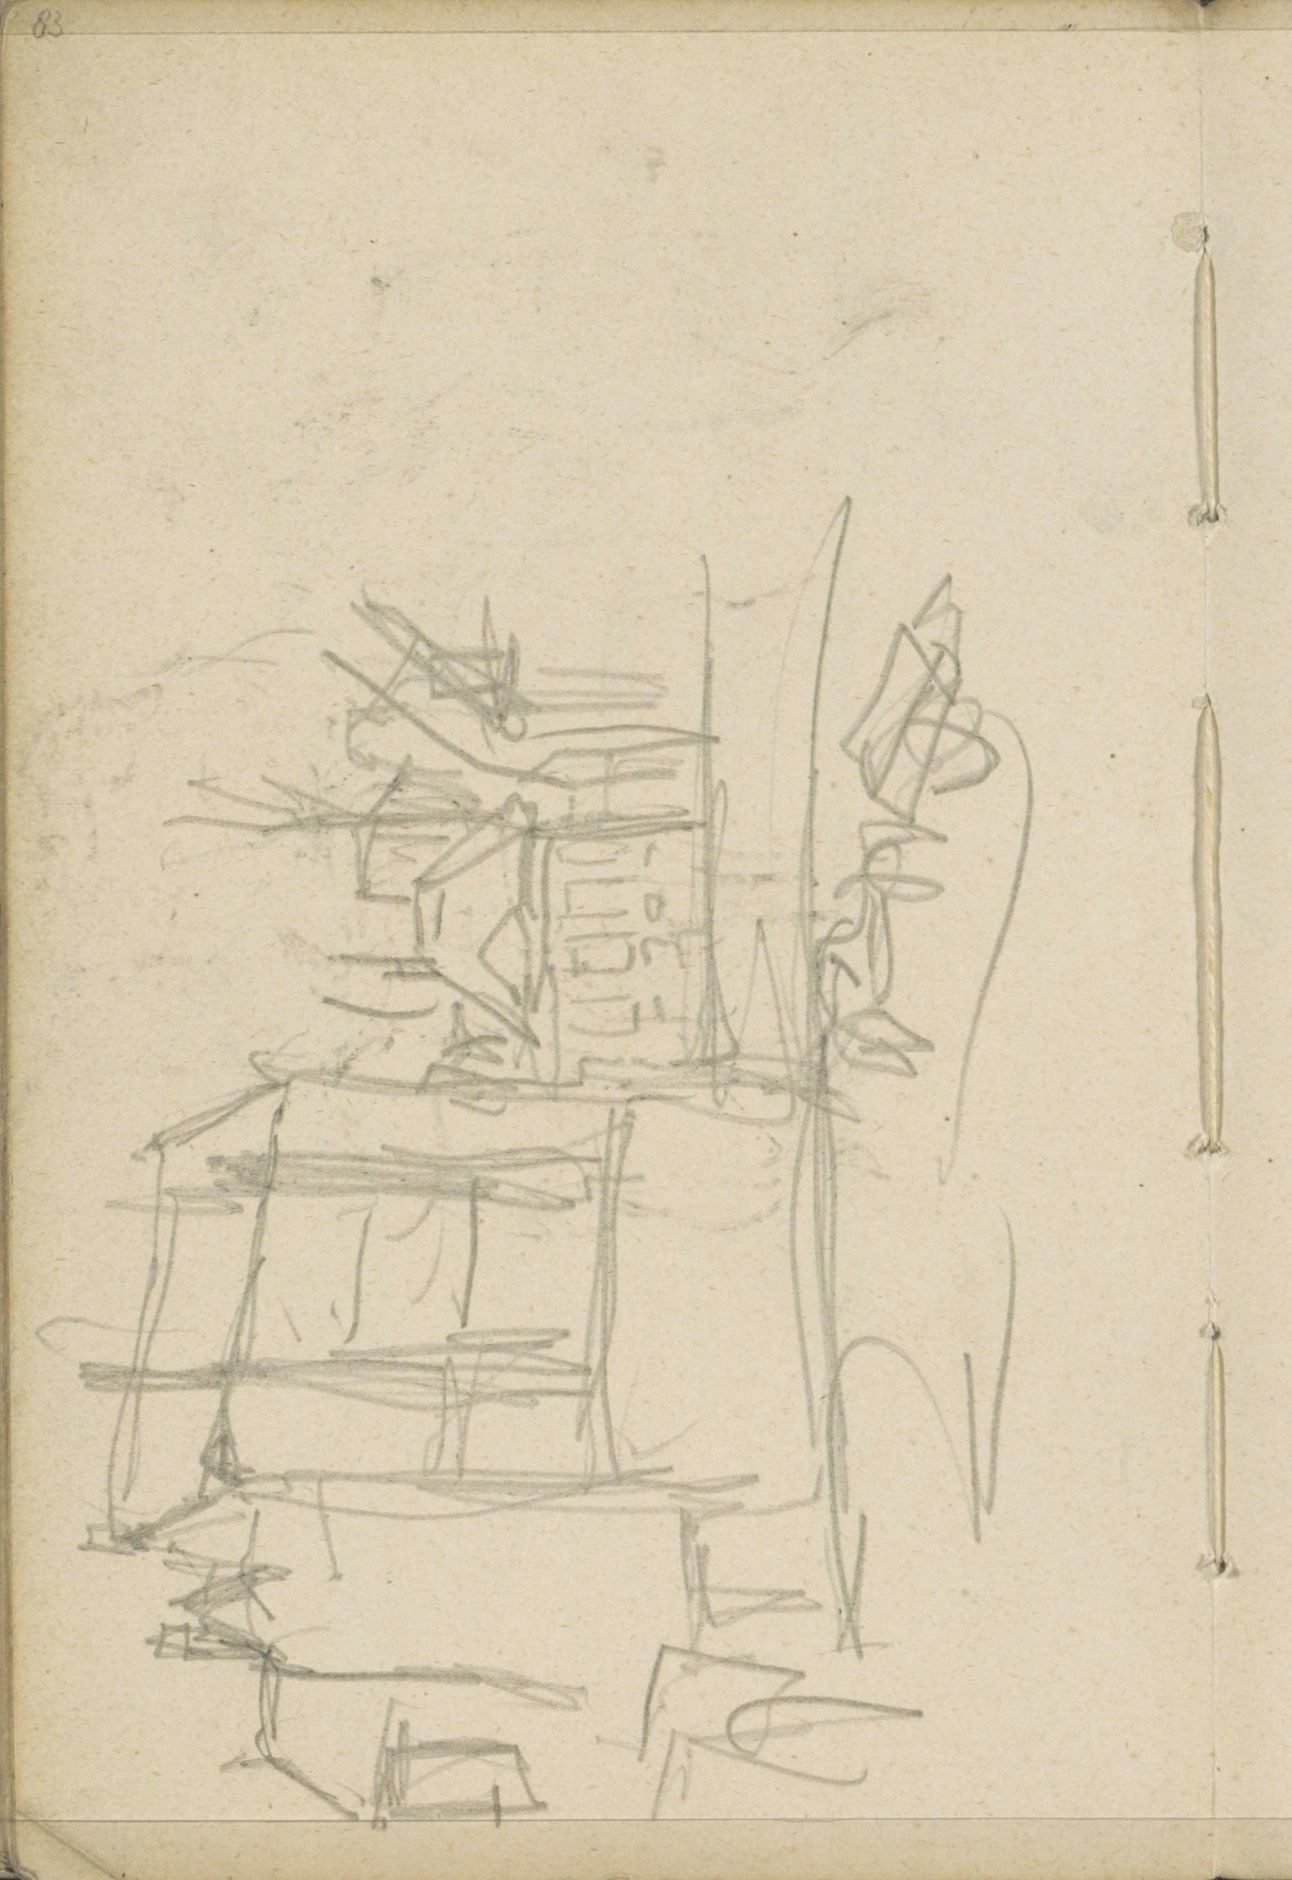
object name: sketchbook leaf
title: Gezicht op gebouwen in Amsterdam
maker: george hendrik breitner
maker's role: draughtsman, painter, print maker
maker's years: 1857-1923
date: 1903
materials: paper, pencil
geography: amsterdam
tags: urban housing, amsterdam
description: Gezicht op gebouwen in Amsterdam. Pagina 83 uit een schetsboek met 46 bladen vervaardigd te Amsterdam en Haarlem.